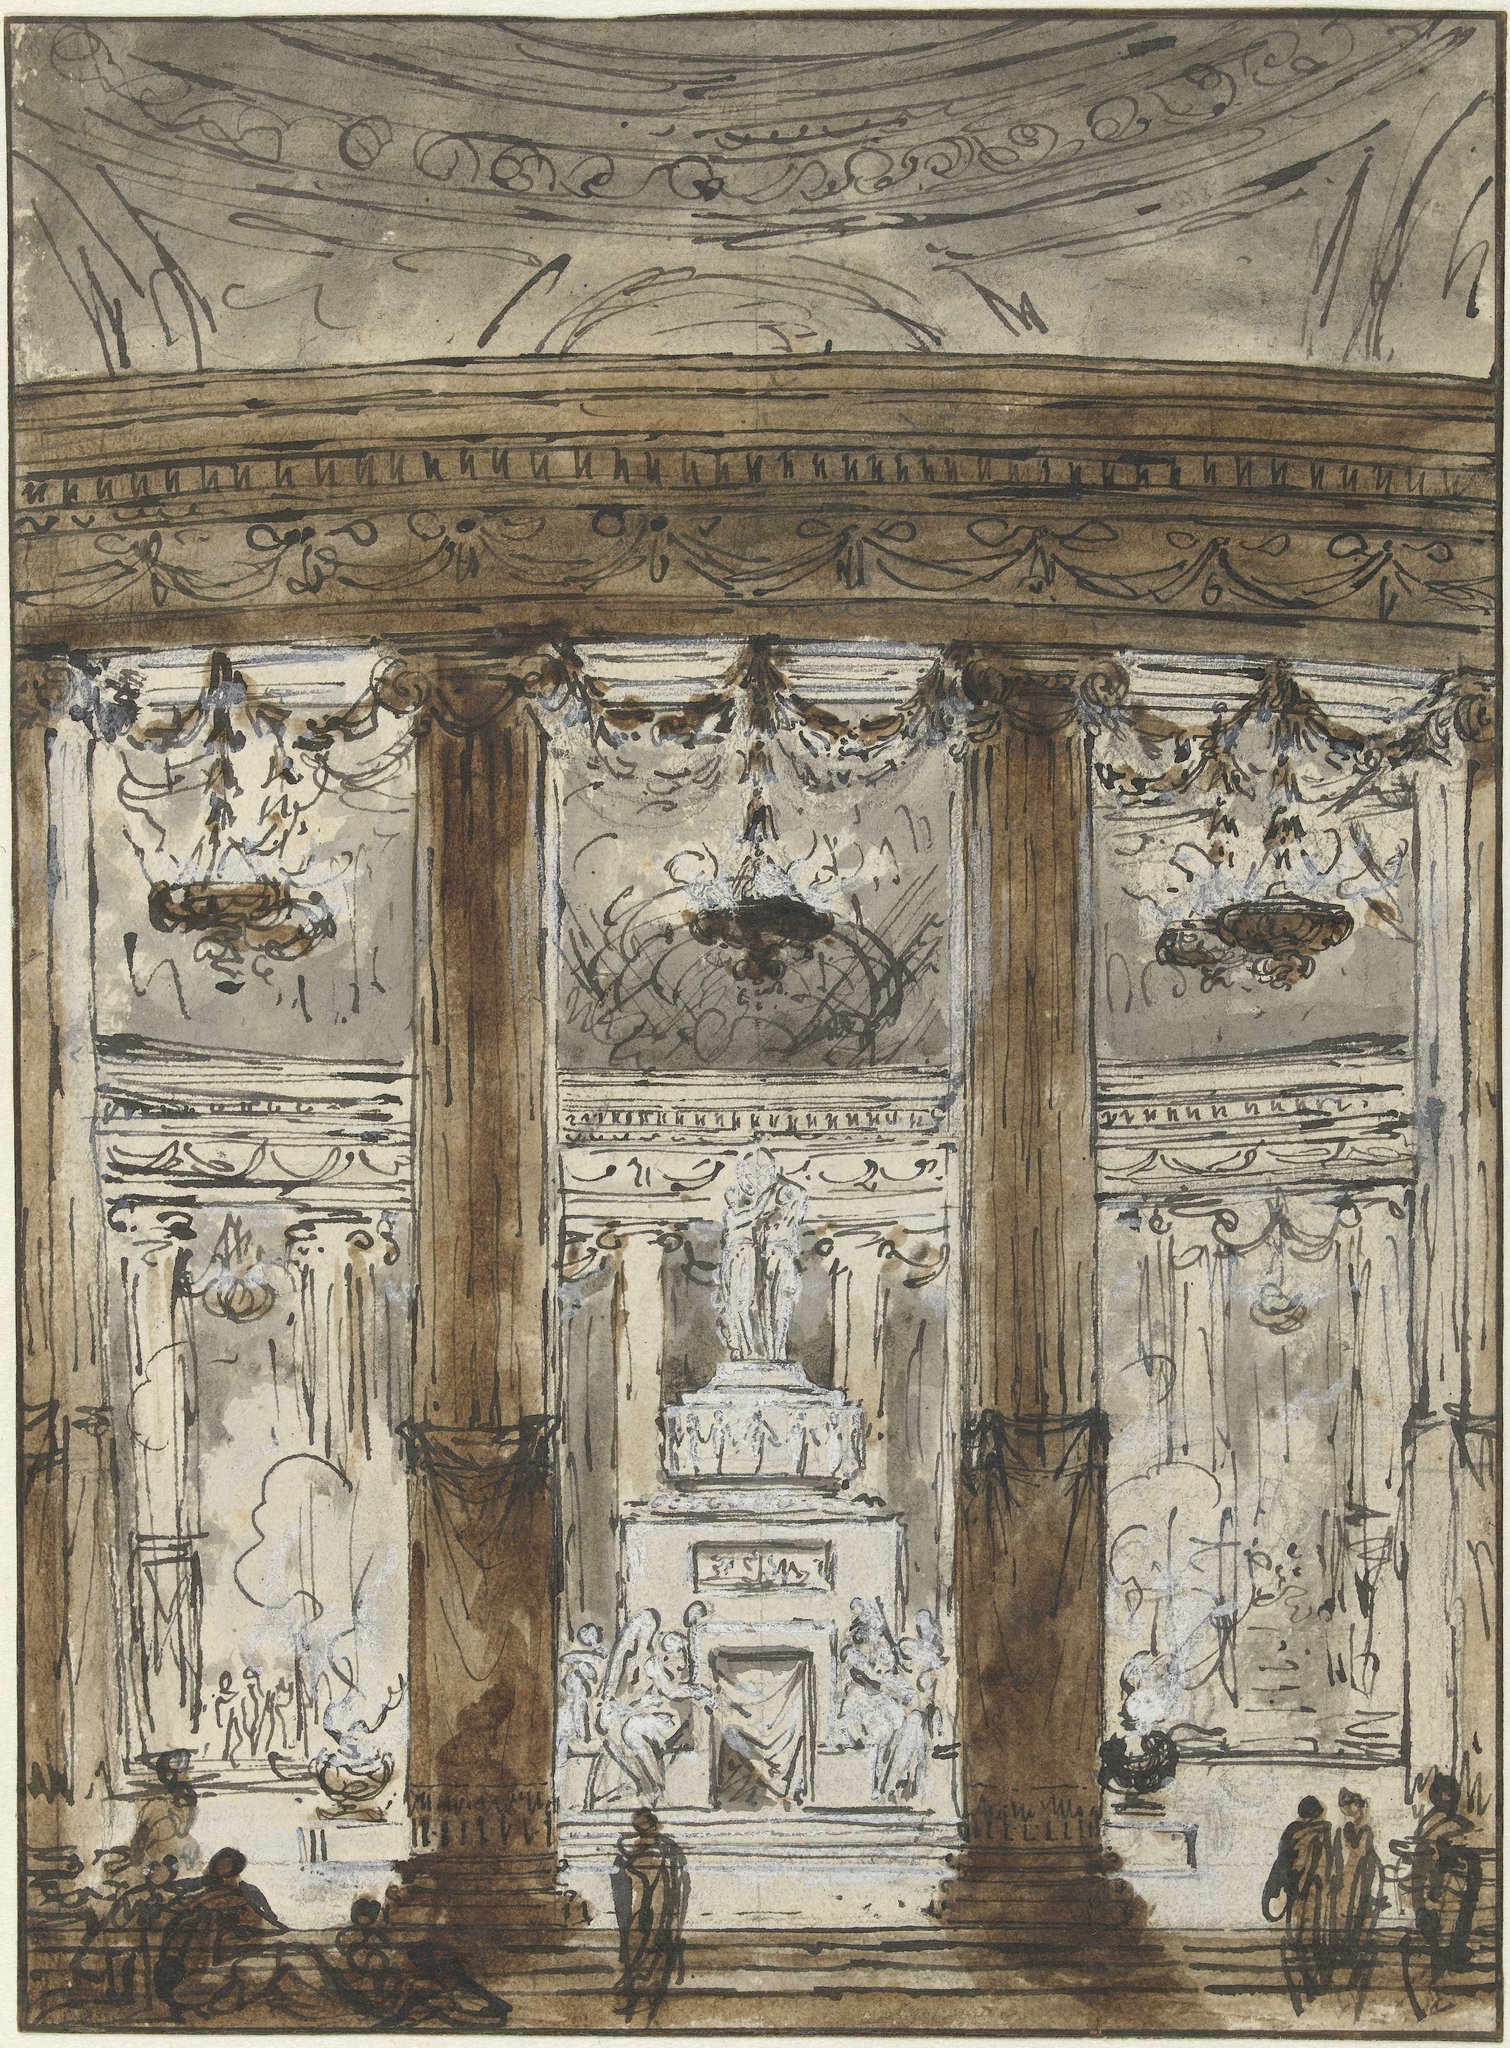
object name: design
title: Interior of a Mausoleum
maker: charles michel-ange challe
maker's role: draughtsman, print maker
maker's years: 1718-1778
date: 1728-1778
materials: ink, paper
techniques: brush, pen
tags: mausoleum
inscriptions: collector's mark, verso, lower centre: Lugt 2228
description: A specialist in architectural drawing and perspective, Challe was also a prolific inventor of theatre and festive decors and imaginary architecture. He based this drawing on the Pantheon in Rome, giving it an exuberant Baroque twist with numerous decorations. He achieved the dramatic chiaroscuro in the foreground by using undiluted brown ink.